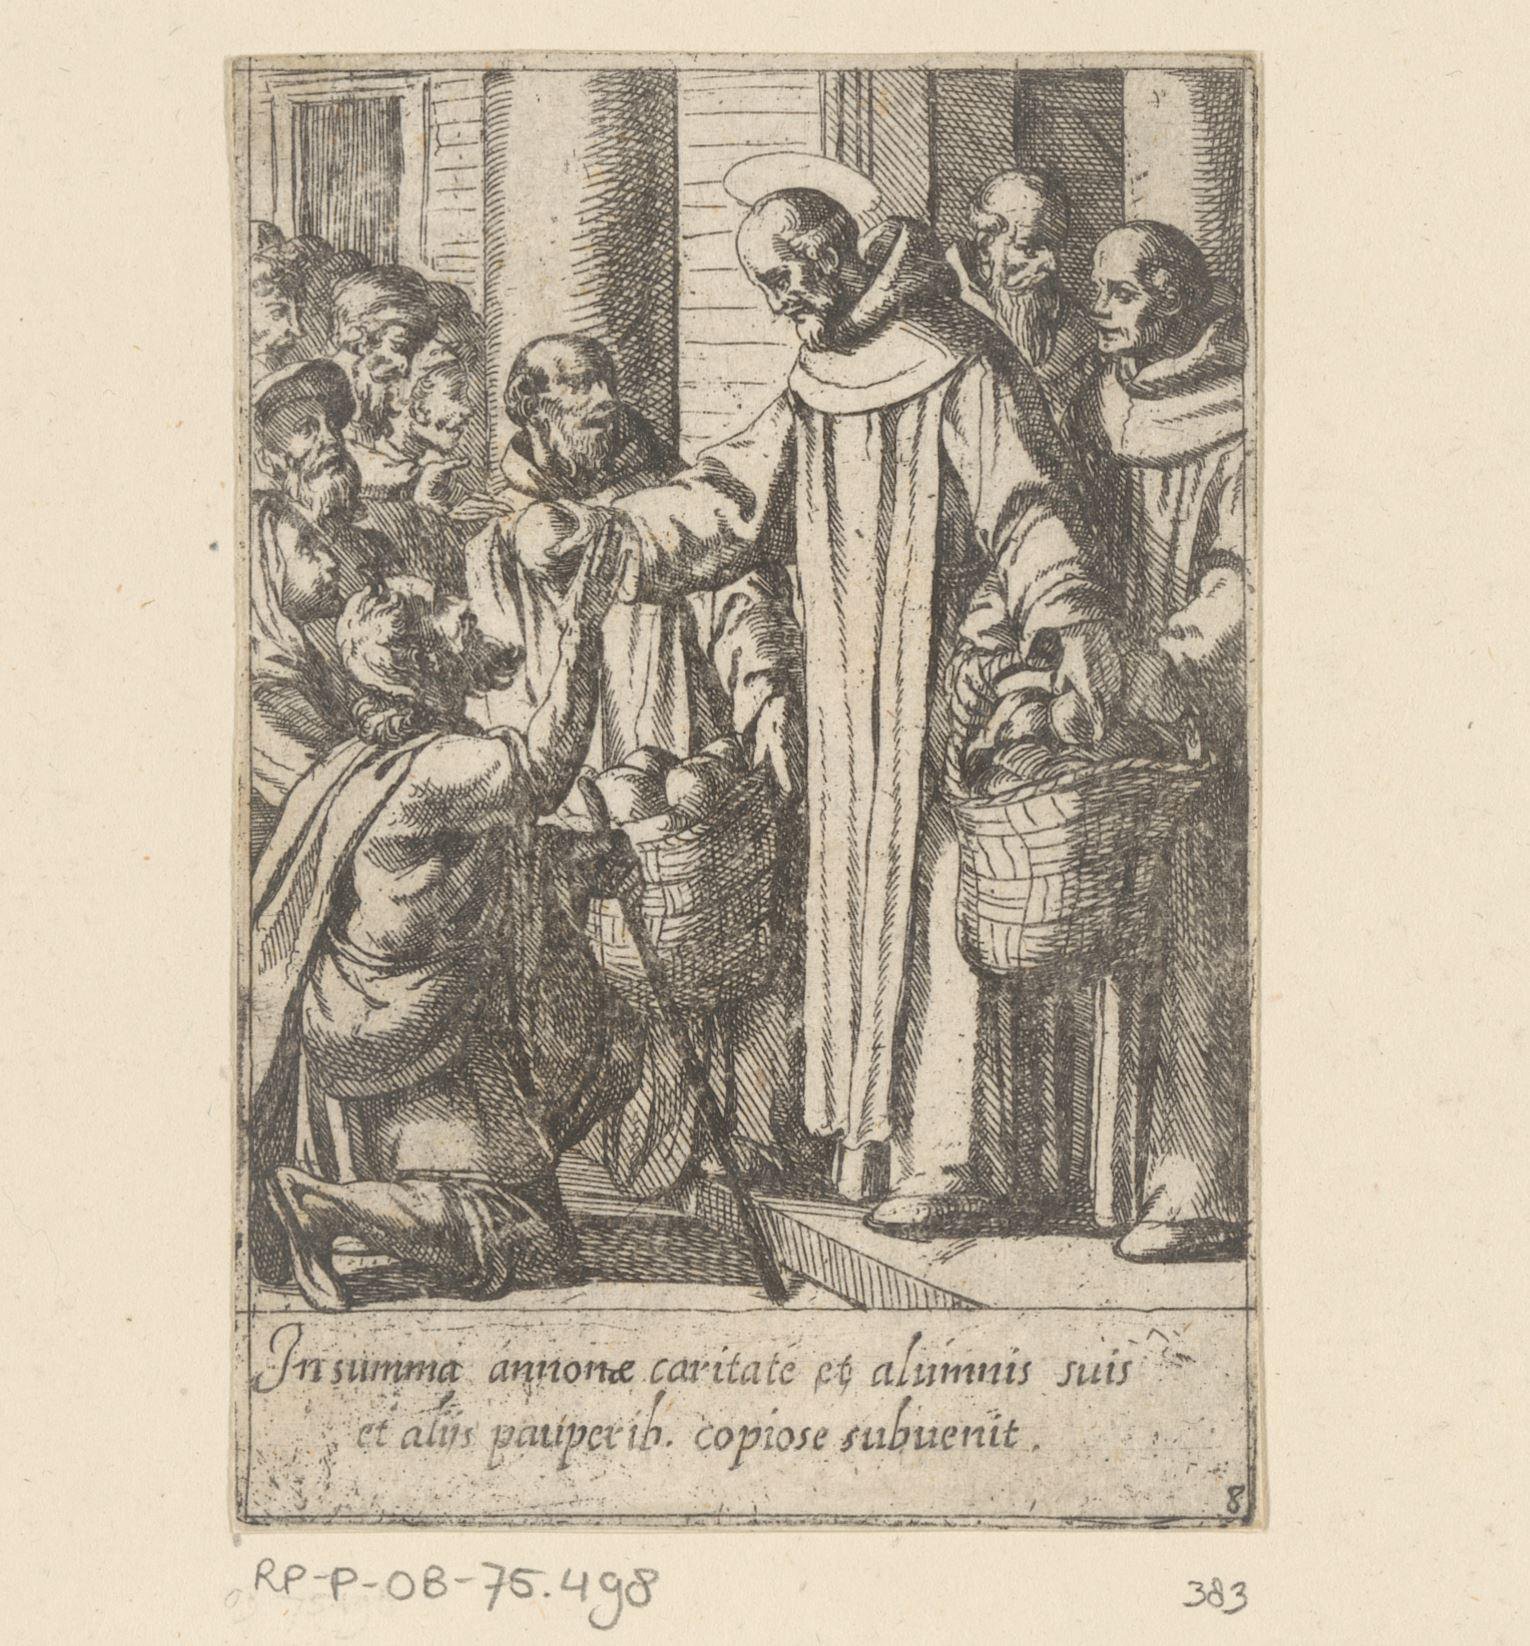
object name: print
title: Het Leven van Philippus Benitius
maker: antonio tempesta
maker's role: draughtsman, painter, print maker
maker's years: 1555-1630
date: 1591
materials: paper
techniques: etching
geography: vatican city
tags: clergyman, prior general of the order of the servites, philip benizzi of florence; possible attributes: book, cross, lily, tiara at his feet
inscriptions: collector's mark: Lugt 240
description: De heilige Philippus verdeelt het brood dat hij gevonden heeft op de kloostertrappen. Tekst in het Latijn in ondermarge. Genummerd rechtsonder: 8.